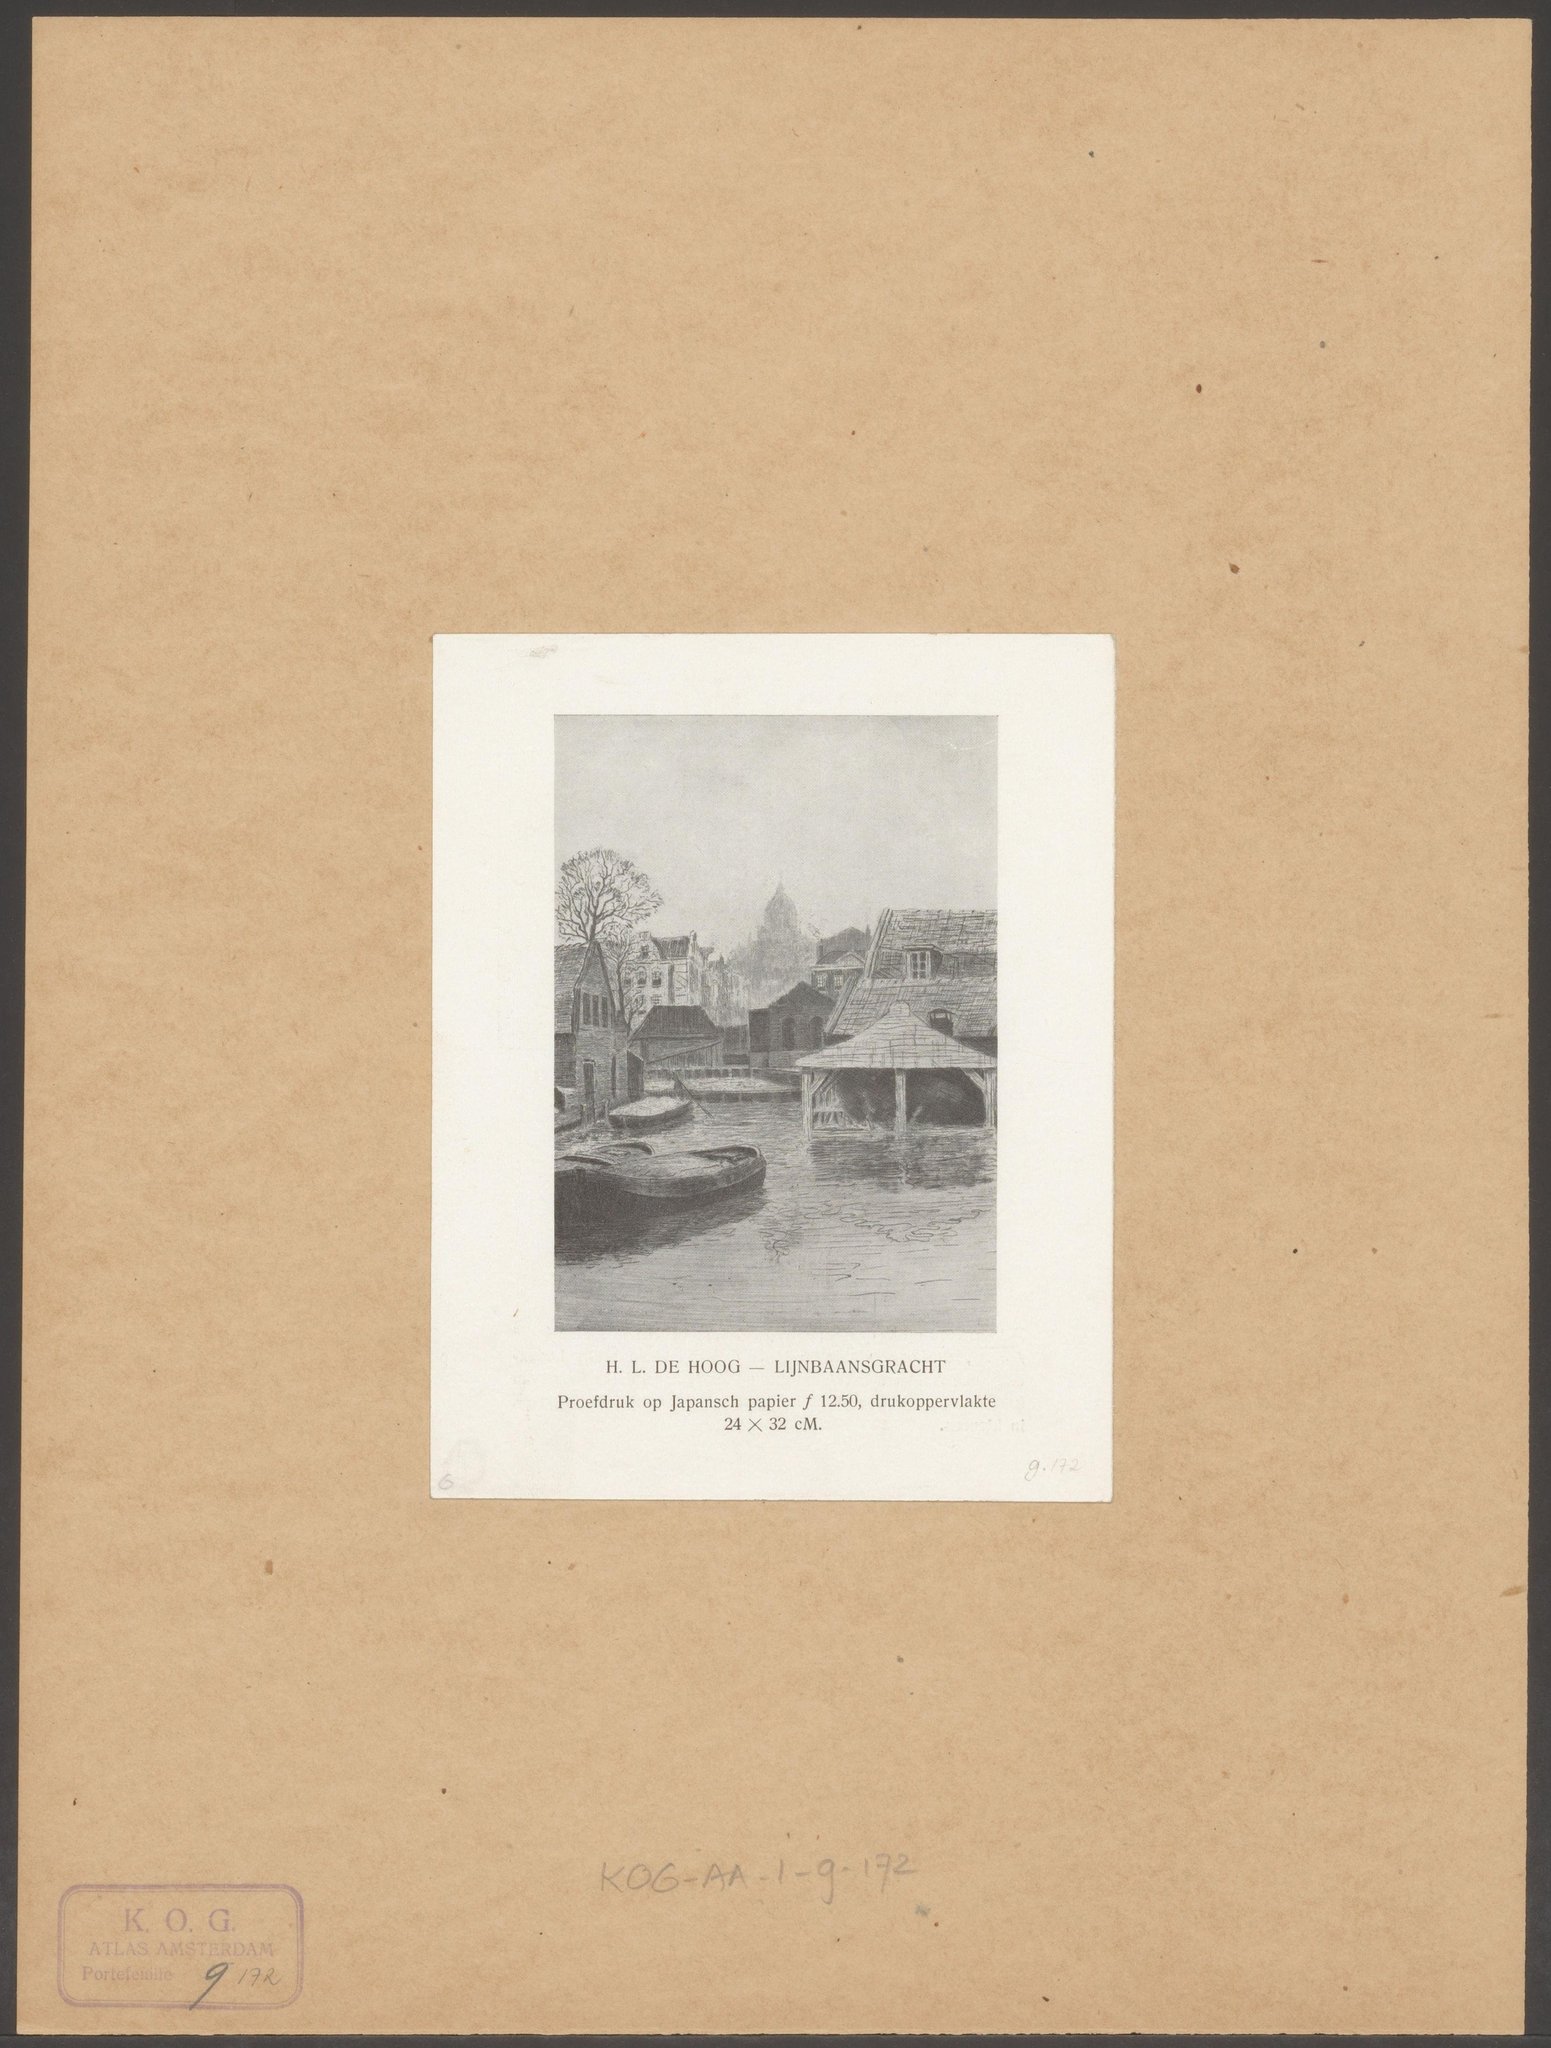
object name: photomechanical print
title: Gezicht op de Lijnbaansgracht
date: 1892-1950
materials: paper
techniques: letterpress printing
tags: city-view in general; 'veduta', parts of church exterior and annexes: dome, canal, boat propelled by man or animal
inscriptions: collector's mark: ‘9.172’ Lugt 1641b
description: Onderwerpsrubriek binnen de Atlas Amsterdam: 2e Laurierdwarsstraat (Vuile Weespad), Leidschegracht, Leidschekade, Leidscheplein, Leidschestraat, v. Lennepkade, Lijnbaansgracht, Lauriergracht, Leliedwarsstraat, Leliegracht, Lindengracht, Lombardsteeg, Looiersgracht, Looiersstraat (Nieuwe), Leidekkerssteeg.